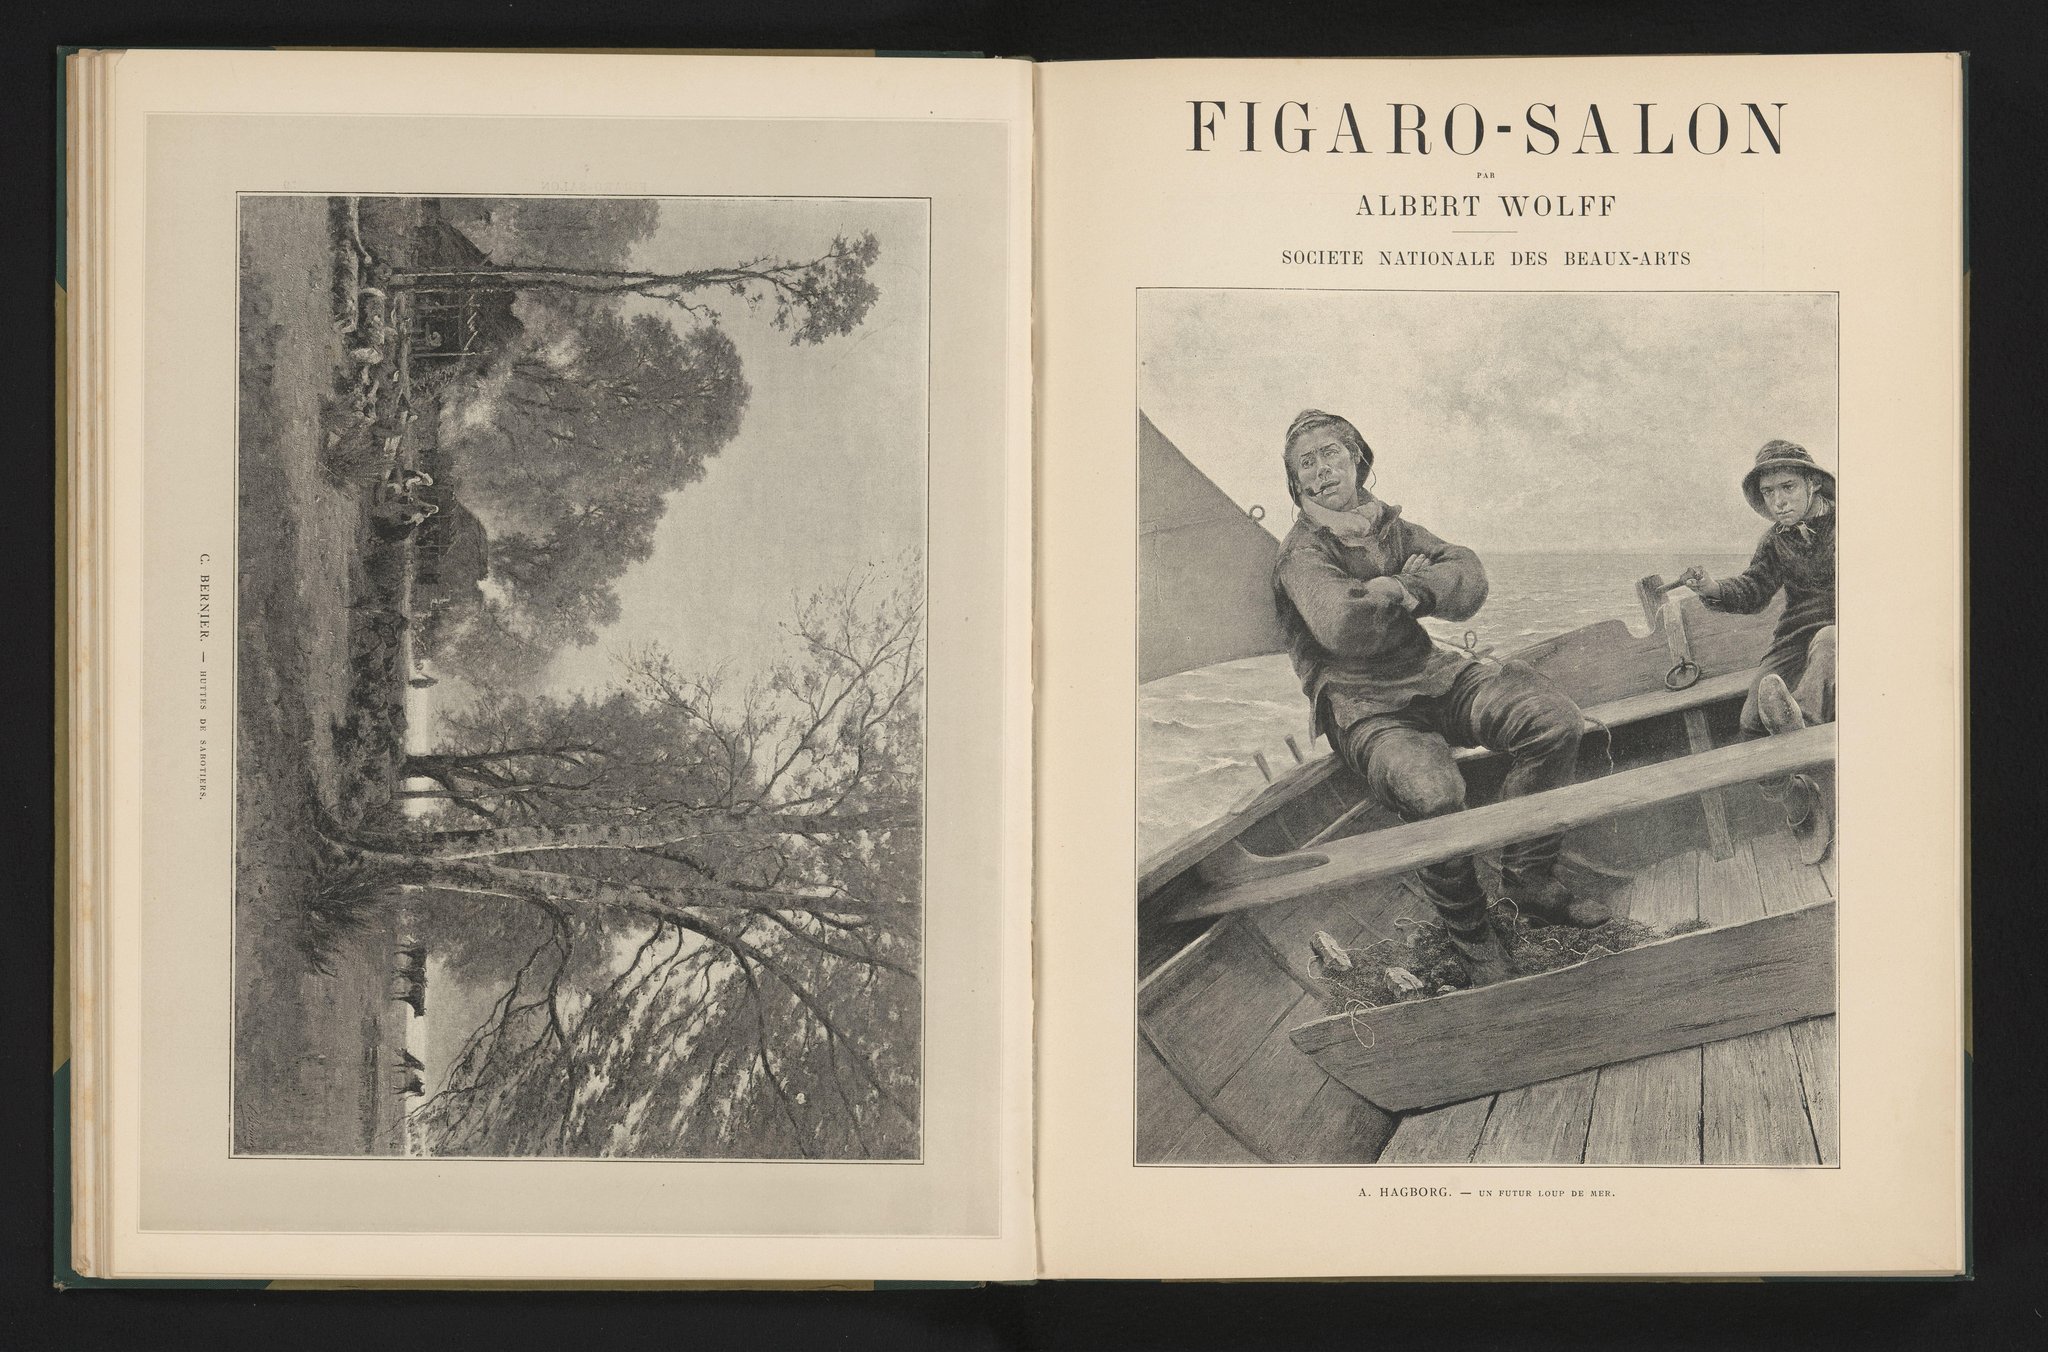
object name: photomechanical print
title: Huttes de sabottiers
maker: Anonymous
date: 1885-1901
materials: paper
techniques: autotype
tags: cow, farm or solitary house in landscape (+ city(-scape) with figures, staffage)